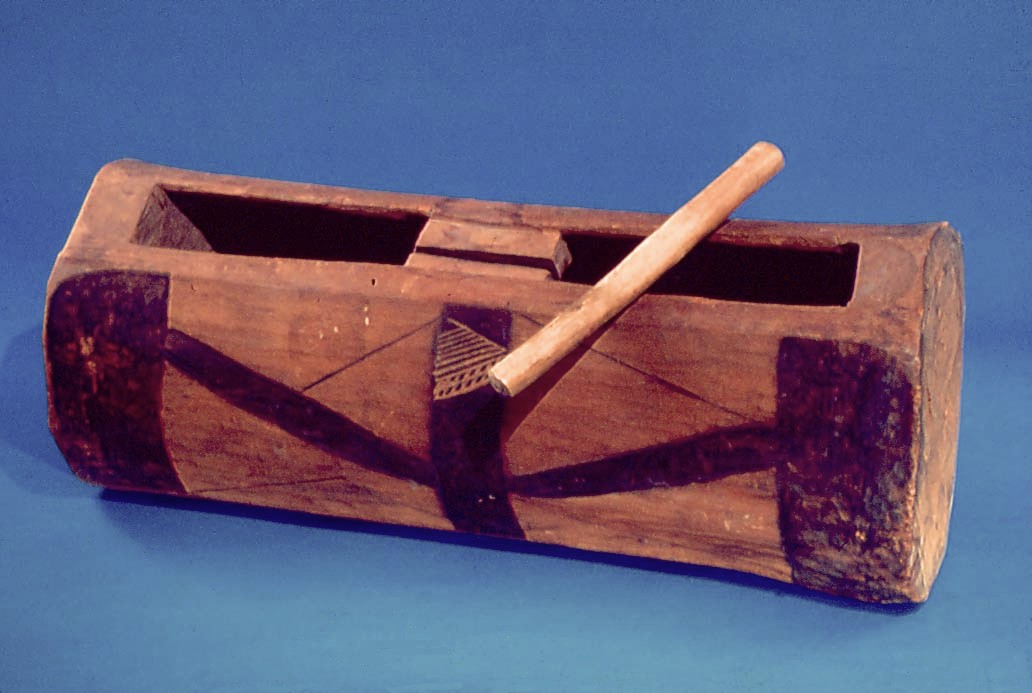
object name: m'kul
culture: fang people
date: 1867-1900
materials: wood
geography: cameroon